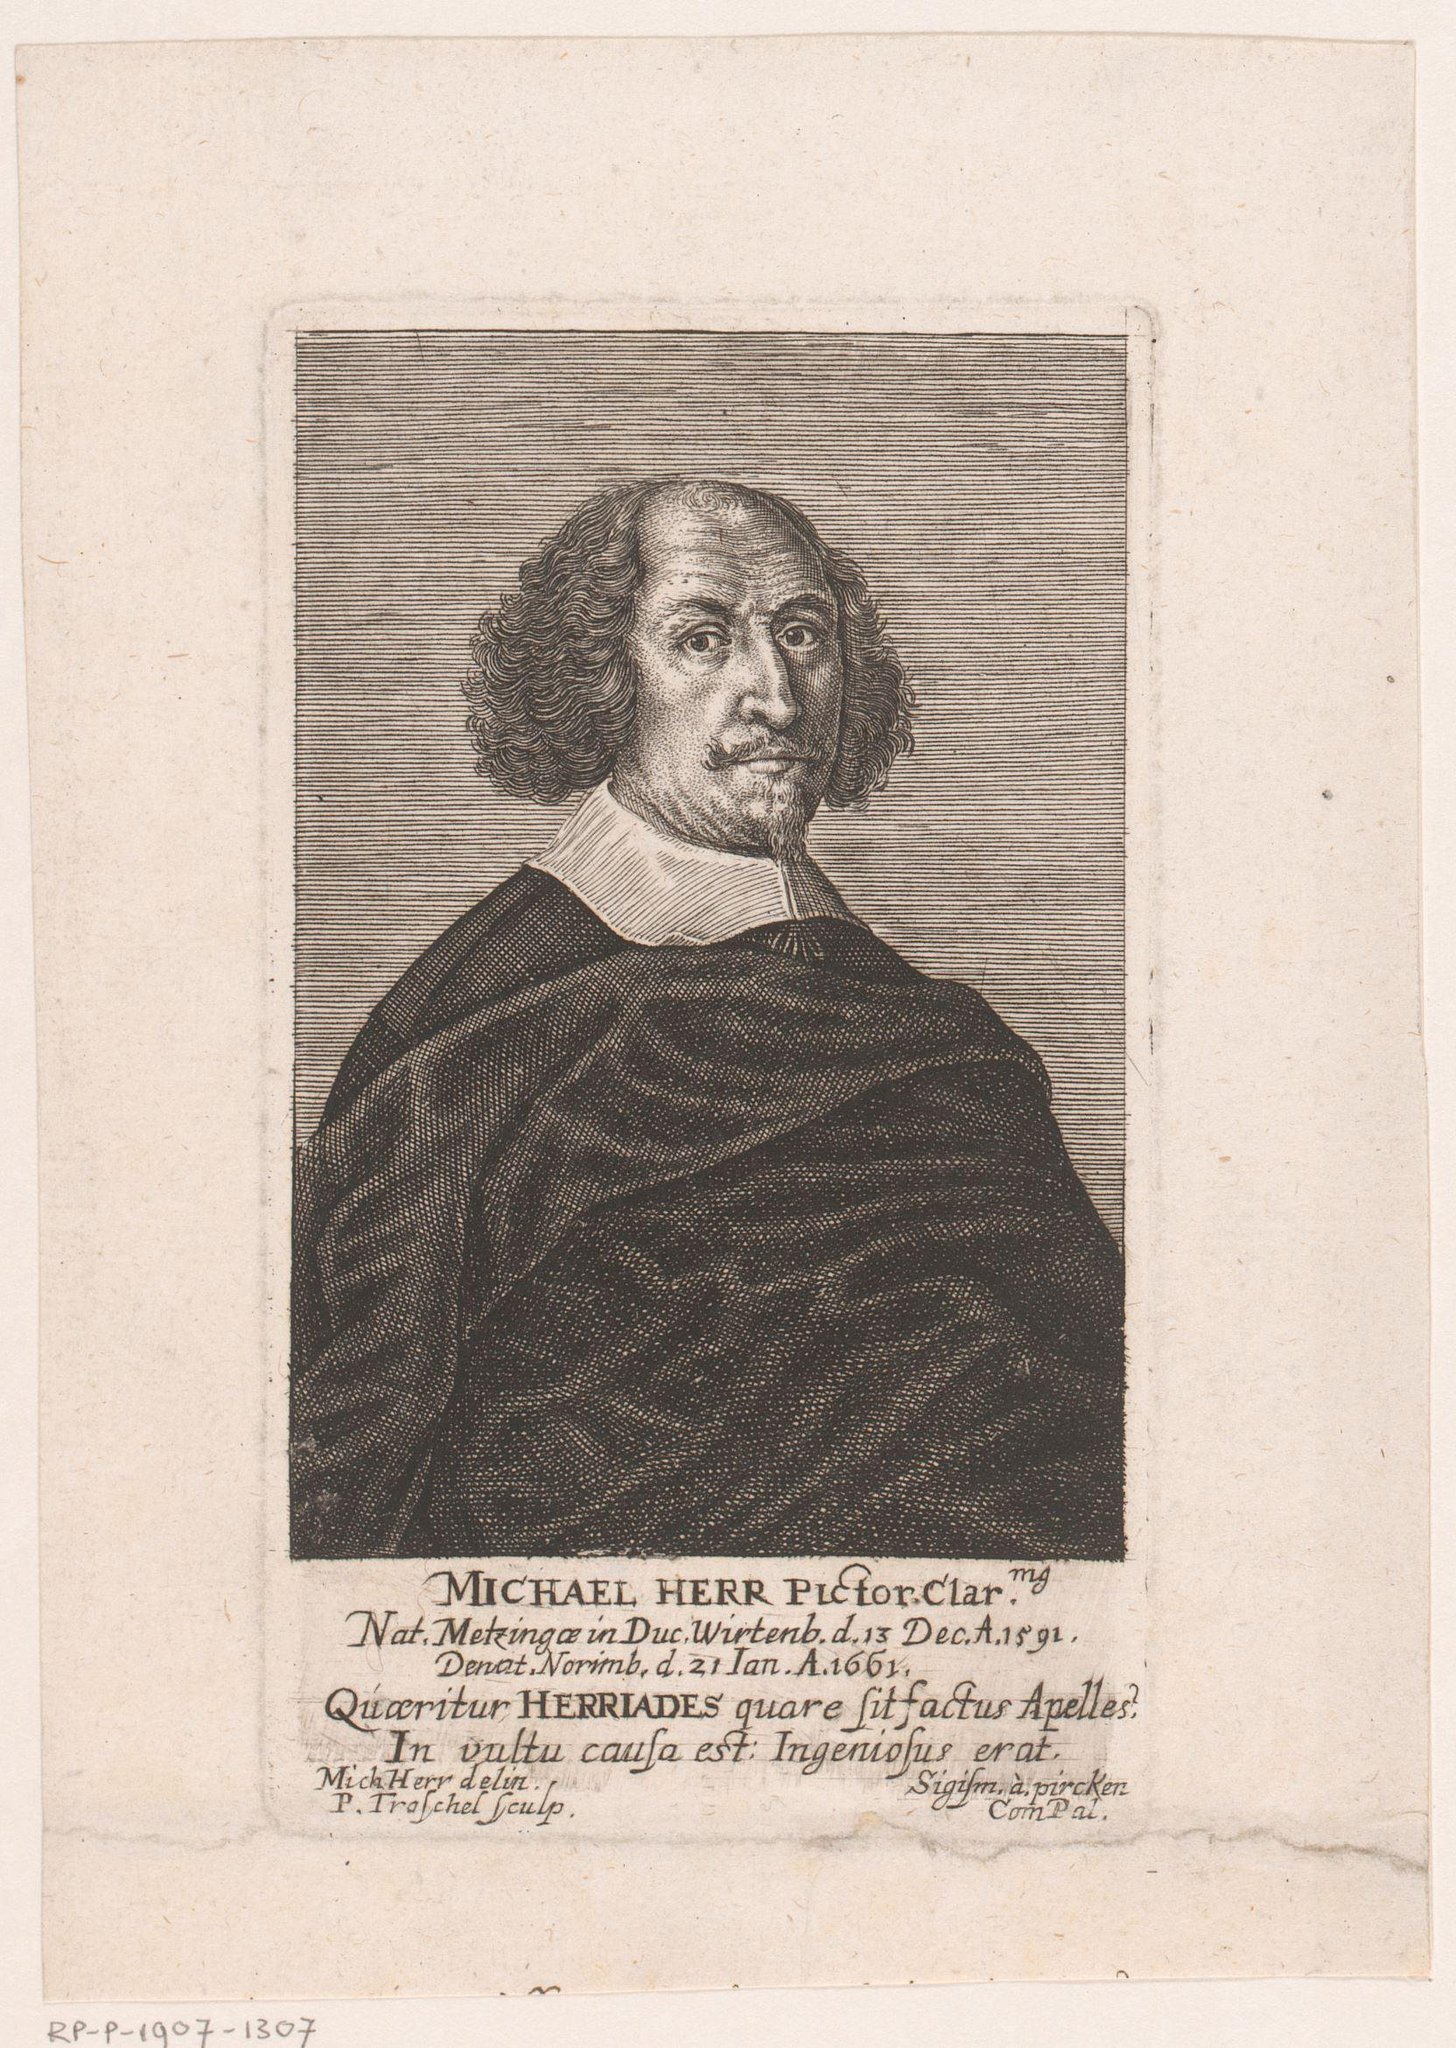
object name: print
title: Portret van Michael Herr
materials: paper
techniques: engraving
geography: germany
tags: painter, print maker, draughtsman, michael herr, historical persons, portrait, self-portrait of artist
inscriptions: collector's mark: Lugt 2228